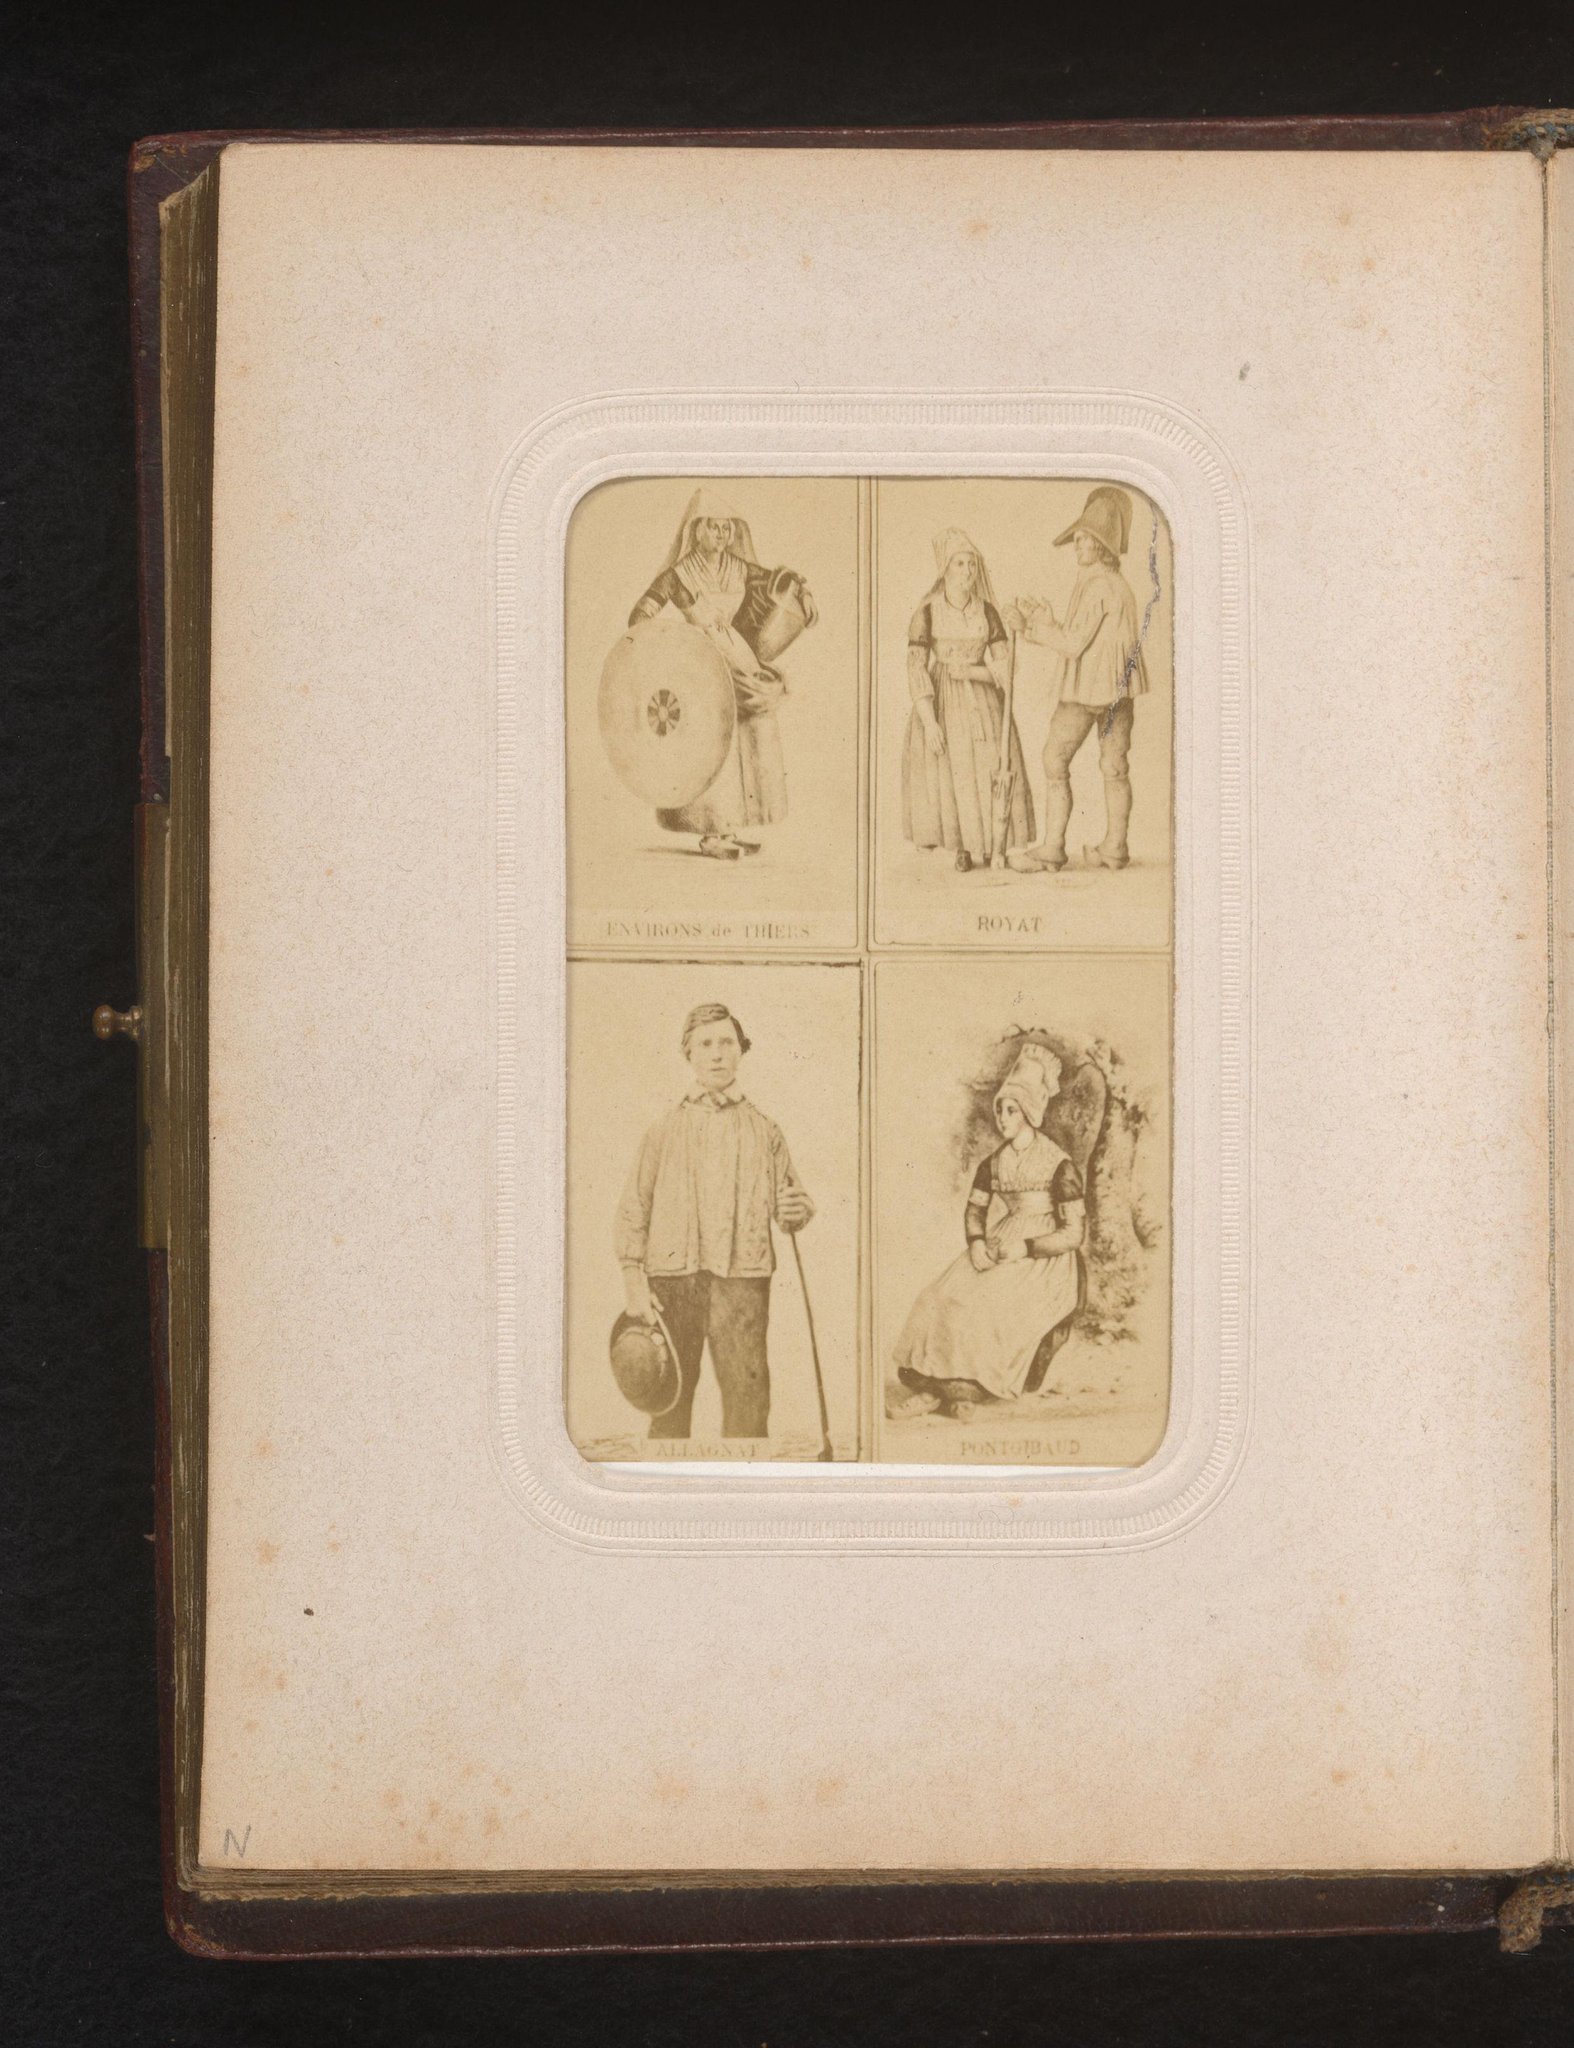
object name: photograph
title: Vier fotoreproducties van tekeningen van mannen en vrouwen in klederdracht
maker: Anonymous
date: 1860-1900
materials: cardboard, photographic support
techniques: albumen print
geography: france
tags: adult woman, adult man, folk costume, regional costume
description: Onder de vier afbeeldingen staat vermeld dat het gaat om klederdracht van onder andere Thiers, Royat, Allagnat en Pontgibaut. Deze foto maakt deel uit van een album.